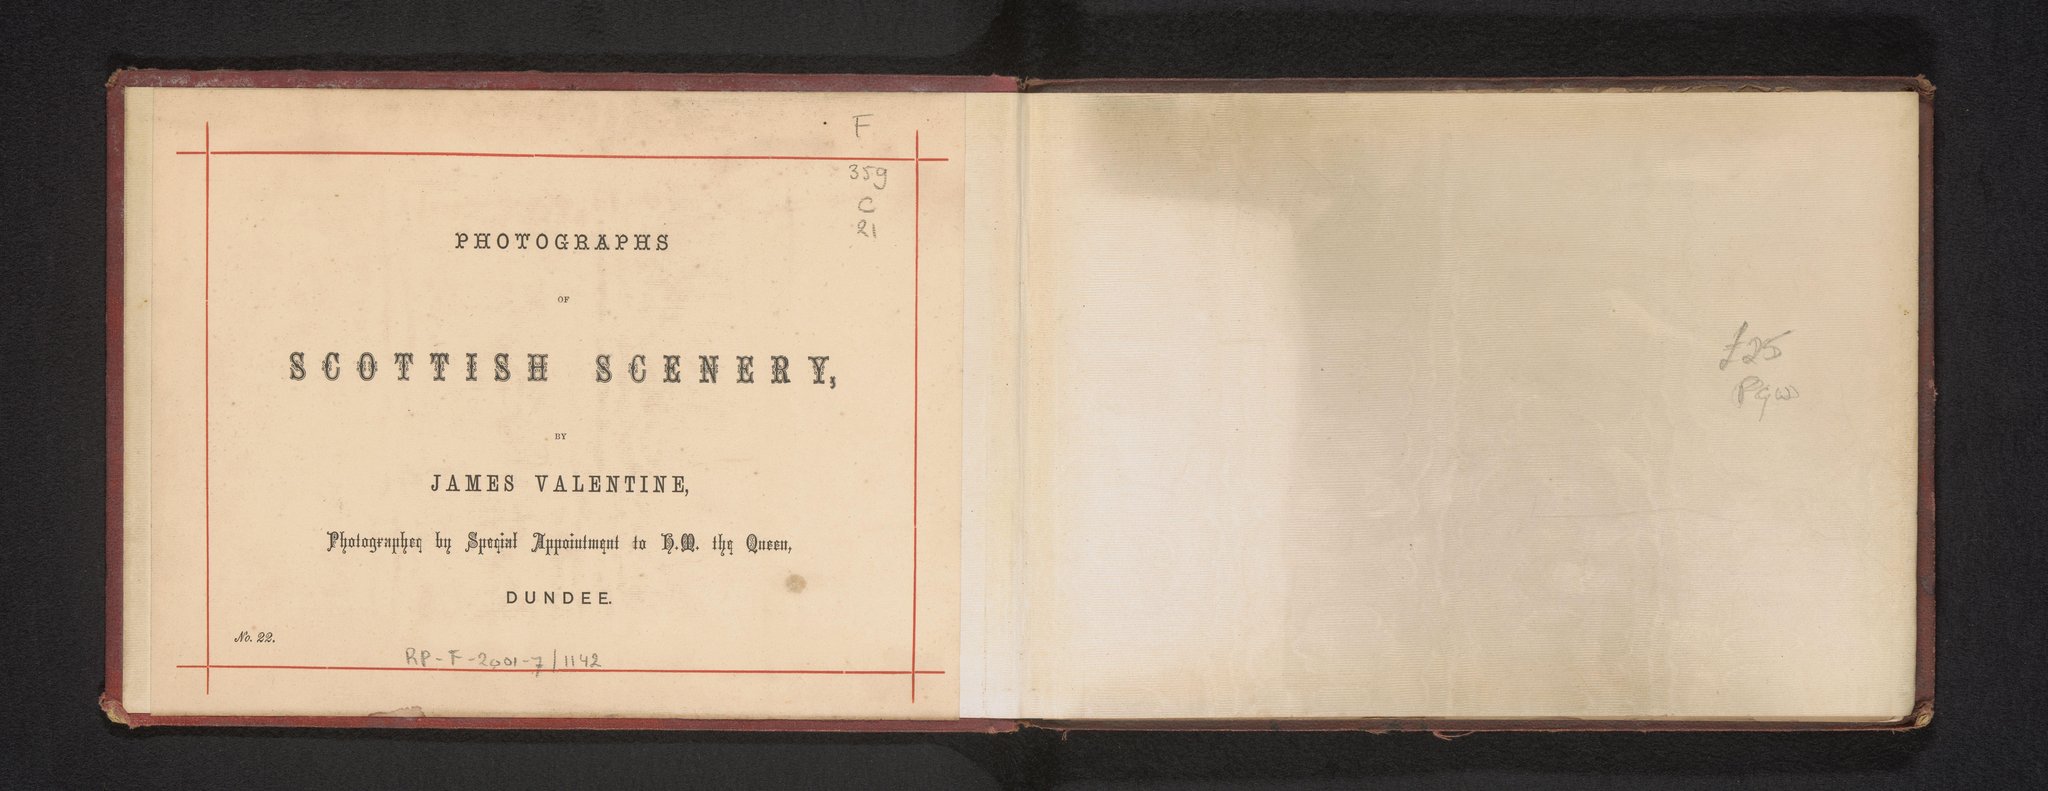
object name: book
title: Photographs of Scottish scenery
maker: james valentine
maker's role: fotograaf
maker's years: 1815-1880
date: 1877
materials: cardboard, paper, photographic support, textile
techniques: albumen print, printing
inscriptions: annotation: ‘OCT/ 1999’